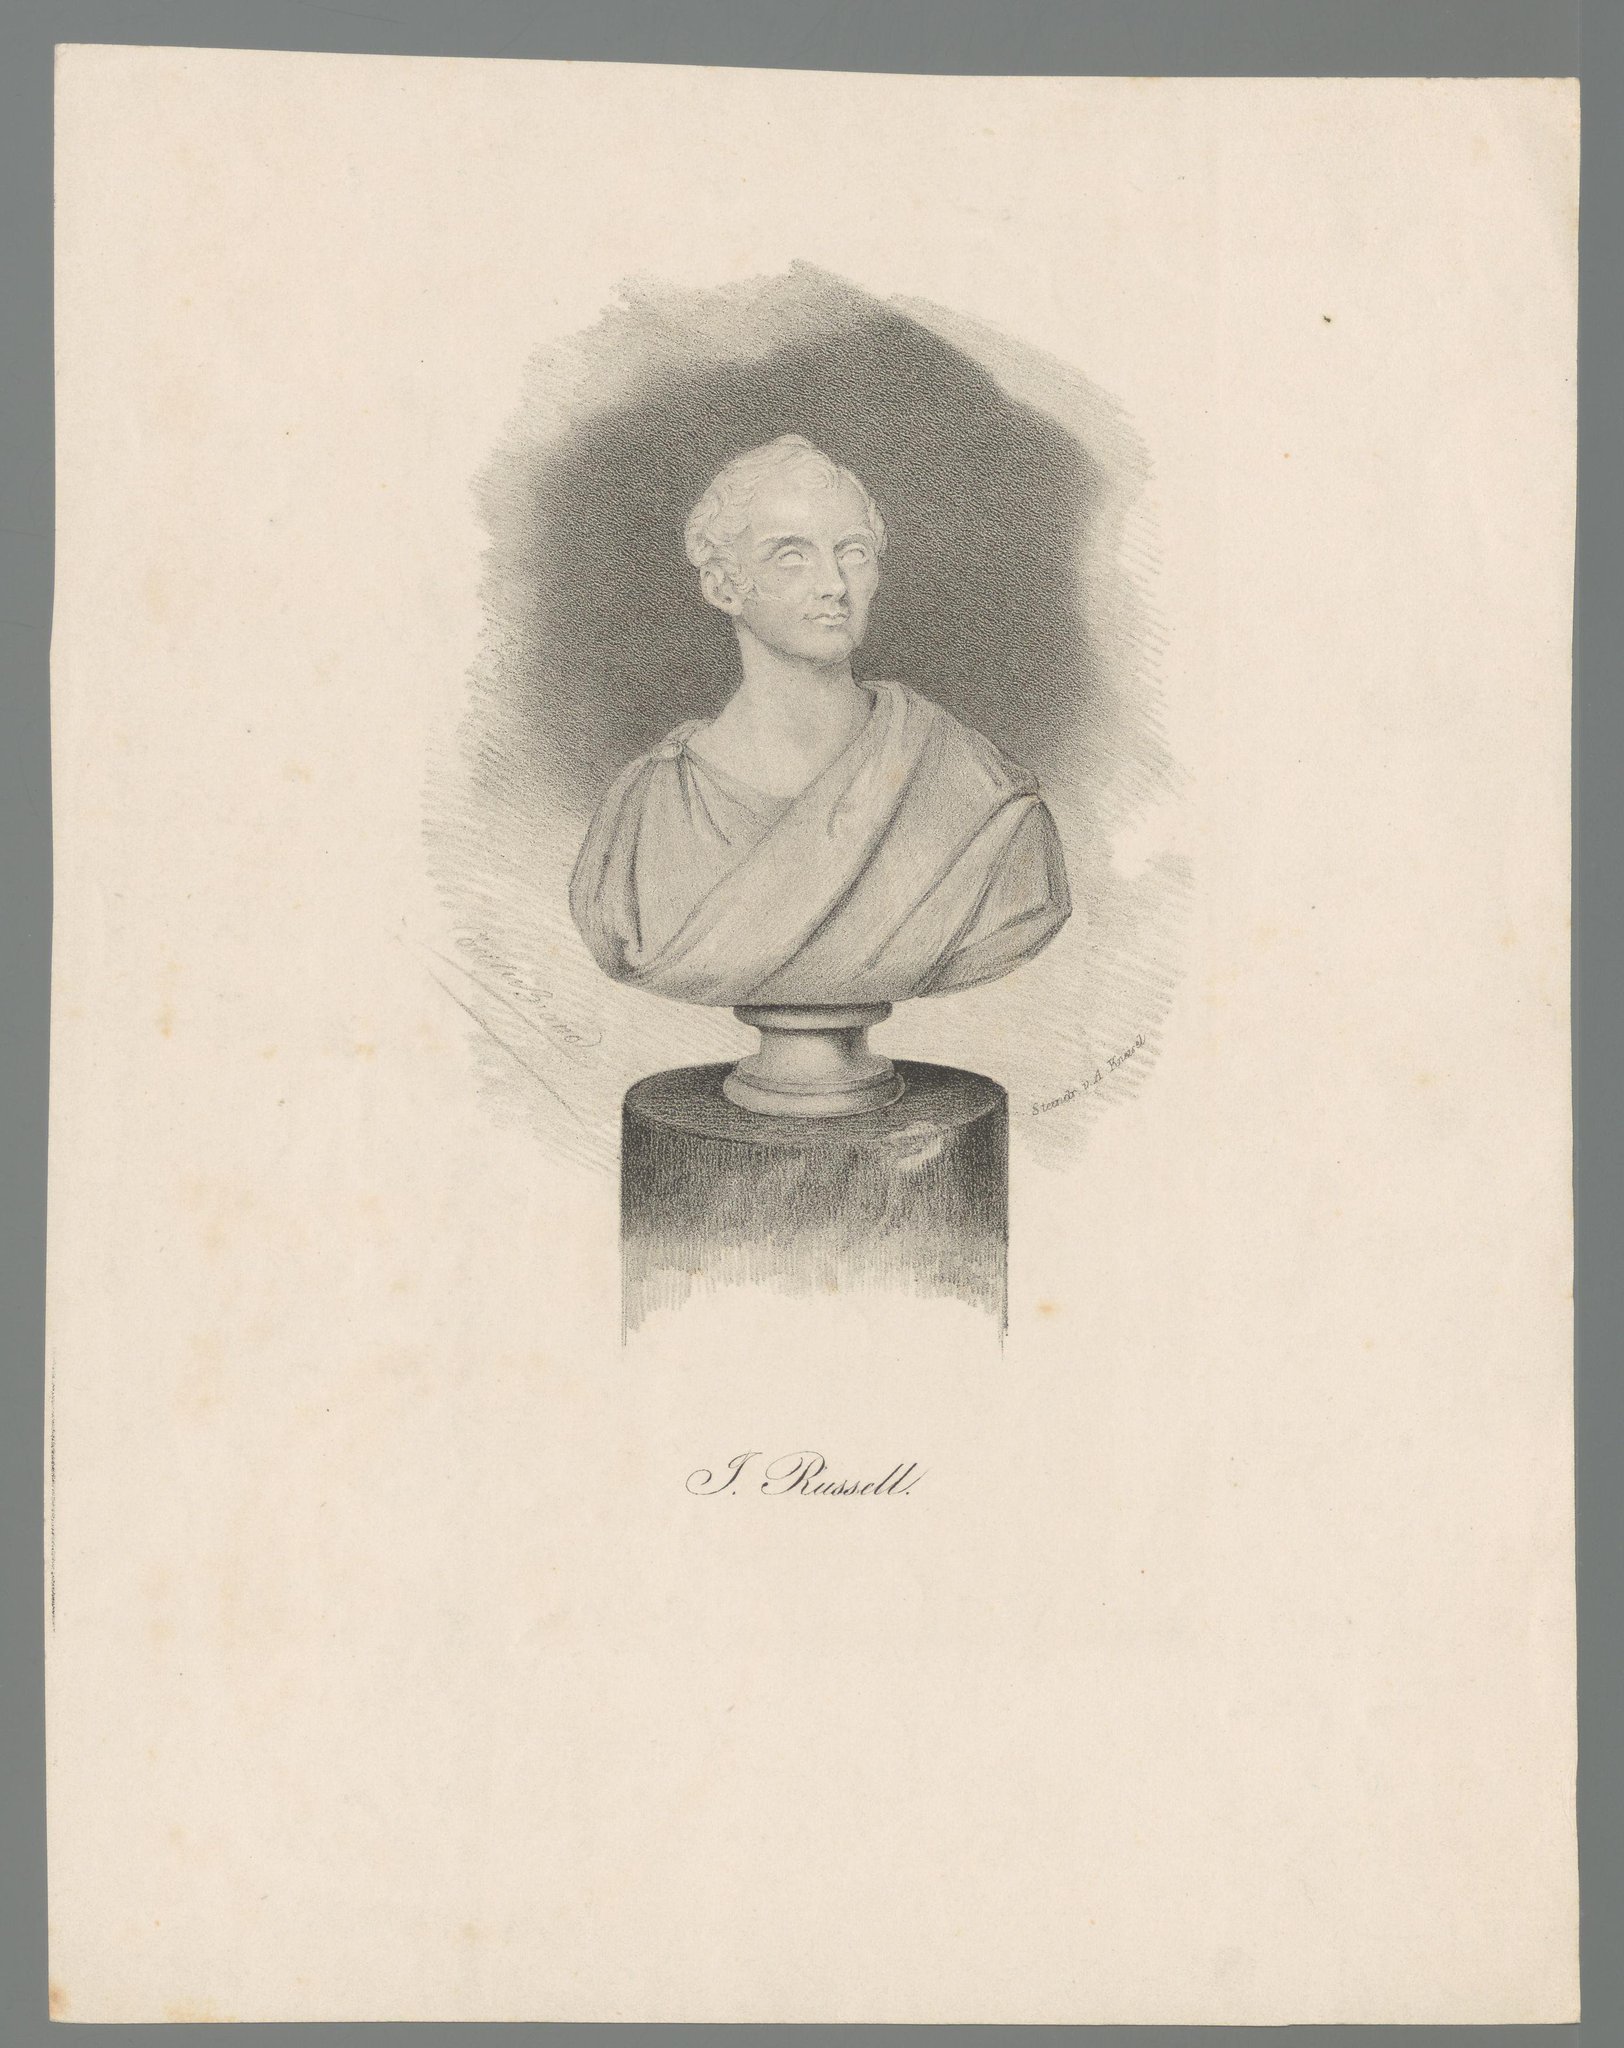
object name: print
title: Portretbuste van John Russell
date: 1825-1850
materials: paper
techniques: lithograph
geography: leipzig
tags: politician, adult man, historical persons, piece of sculpture, reproduction of a piece of sculpture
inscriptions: collector's mark: Lugt 2228